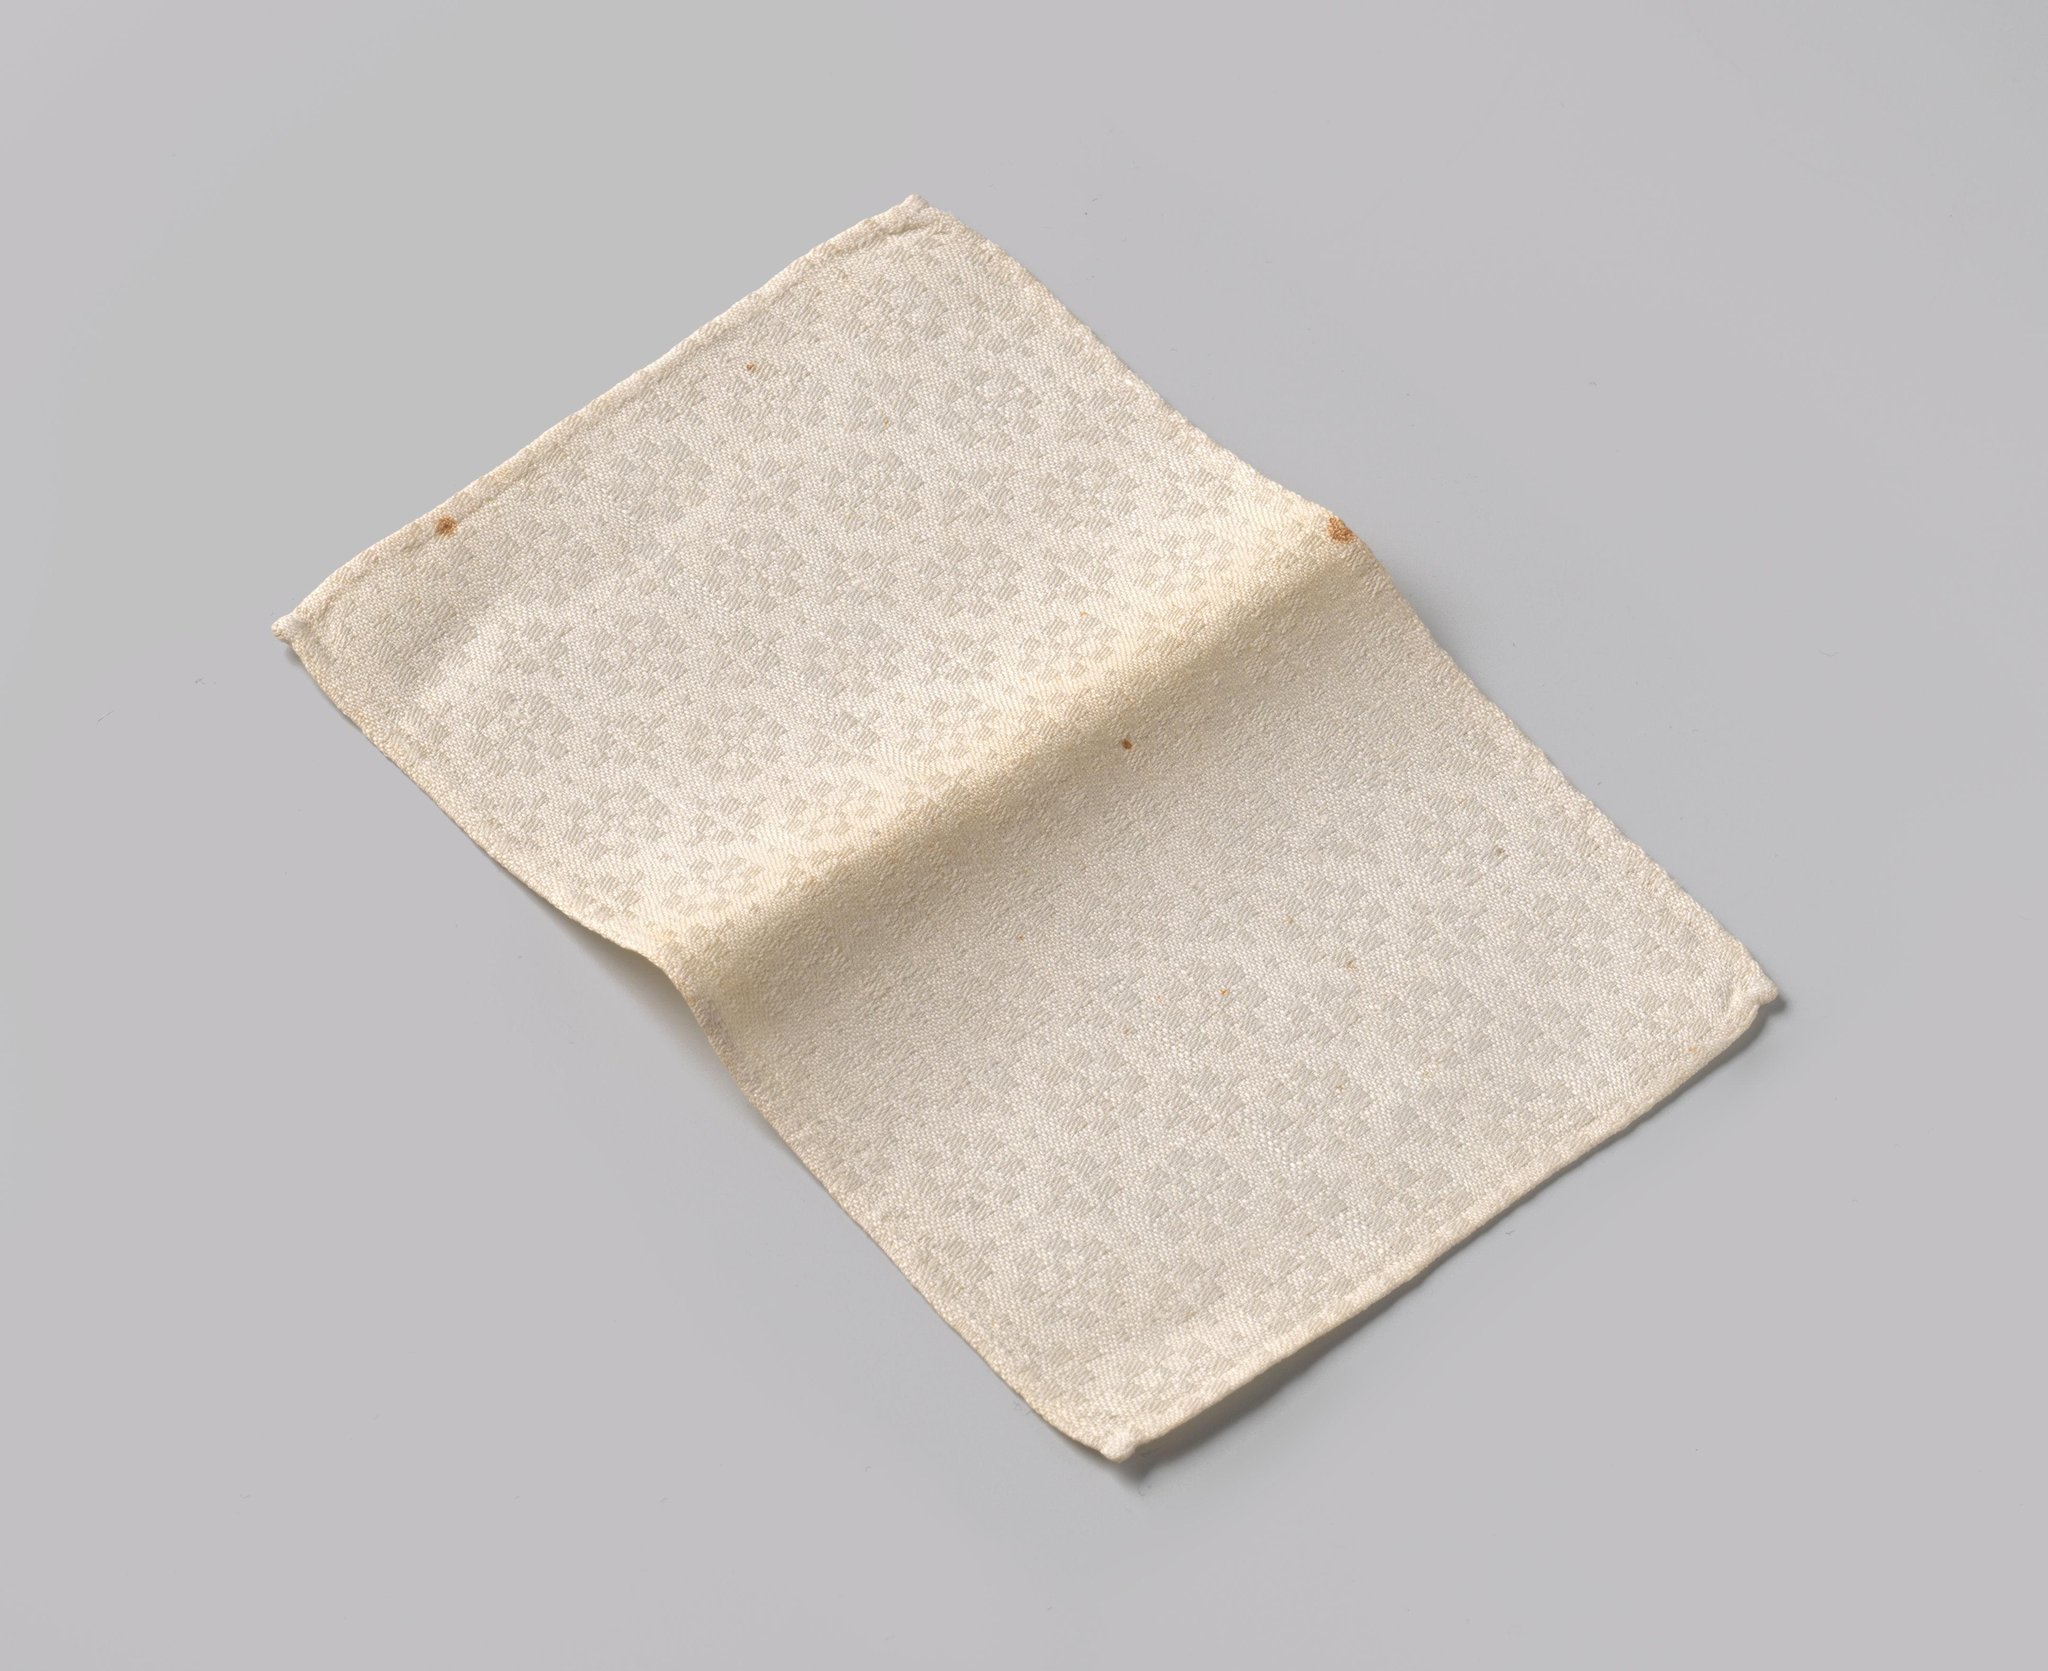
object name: napkin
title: Linnen servet van damastweefsel met pellenpatroon (motief II), aan vier zijden omzoomd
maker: Anonymous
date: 1690-1710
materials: linen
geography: amsterdam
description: Linnen servet, damastweefsel met pellenpatroon (motief II), aan vier zijden omzoomd.